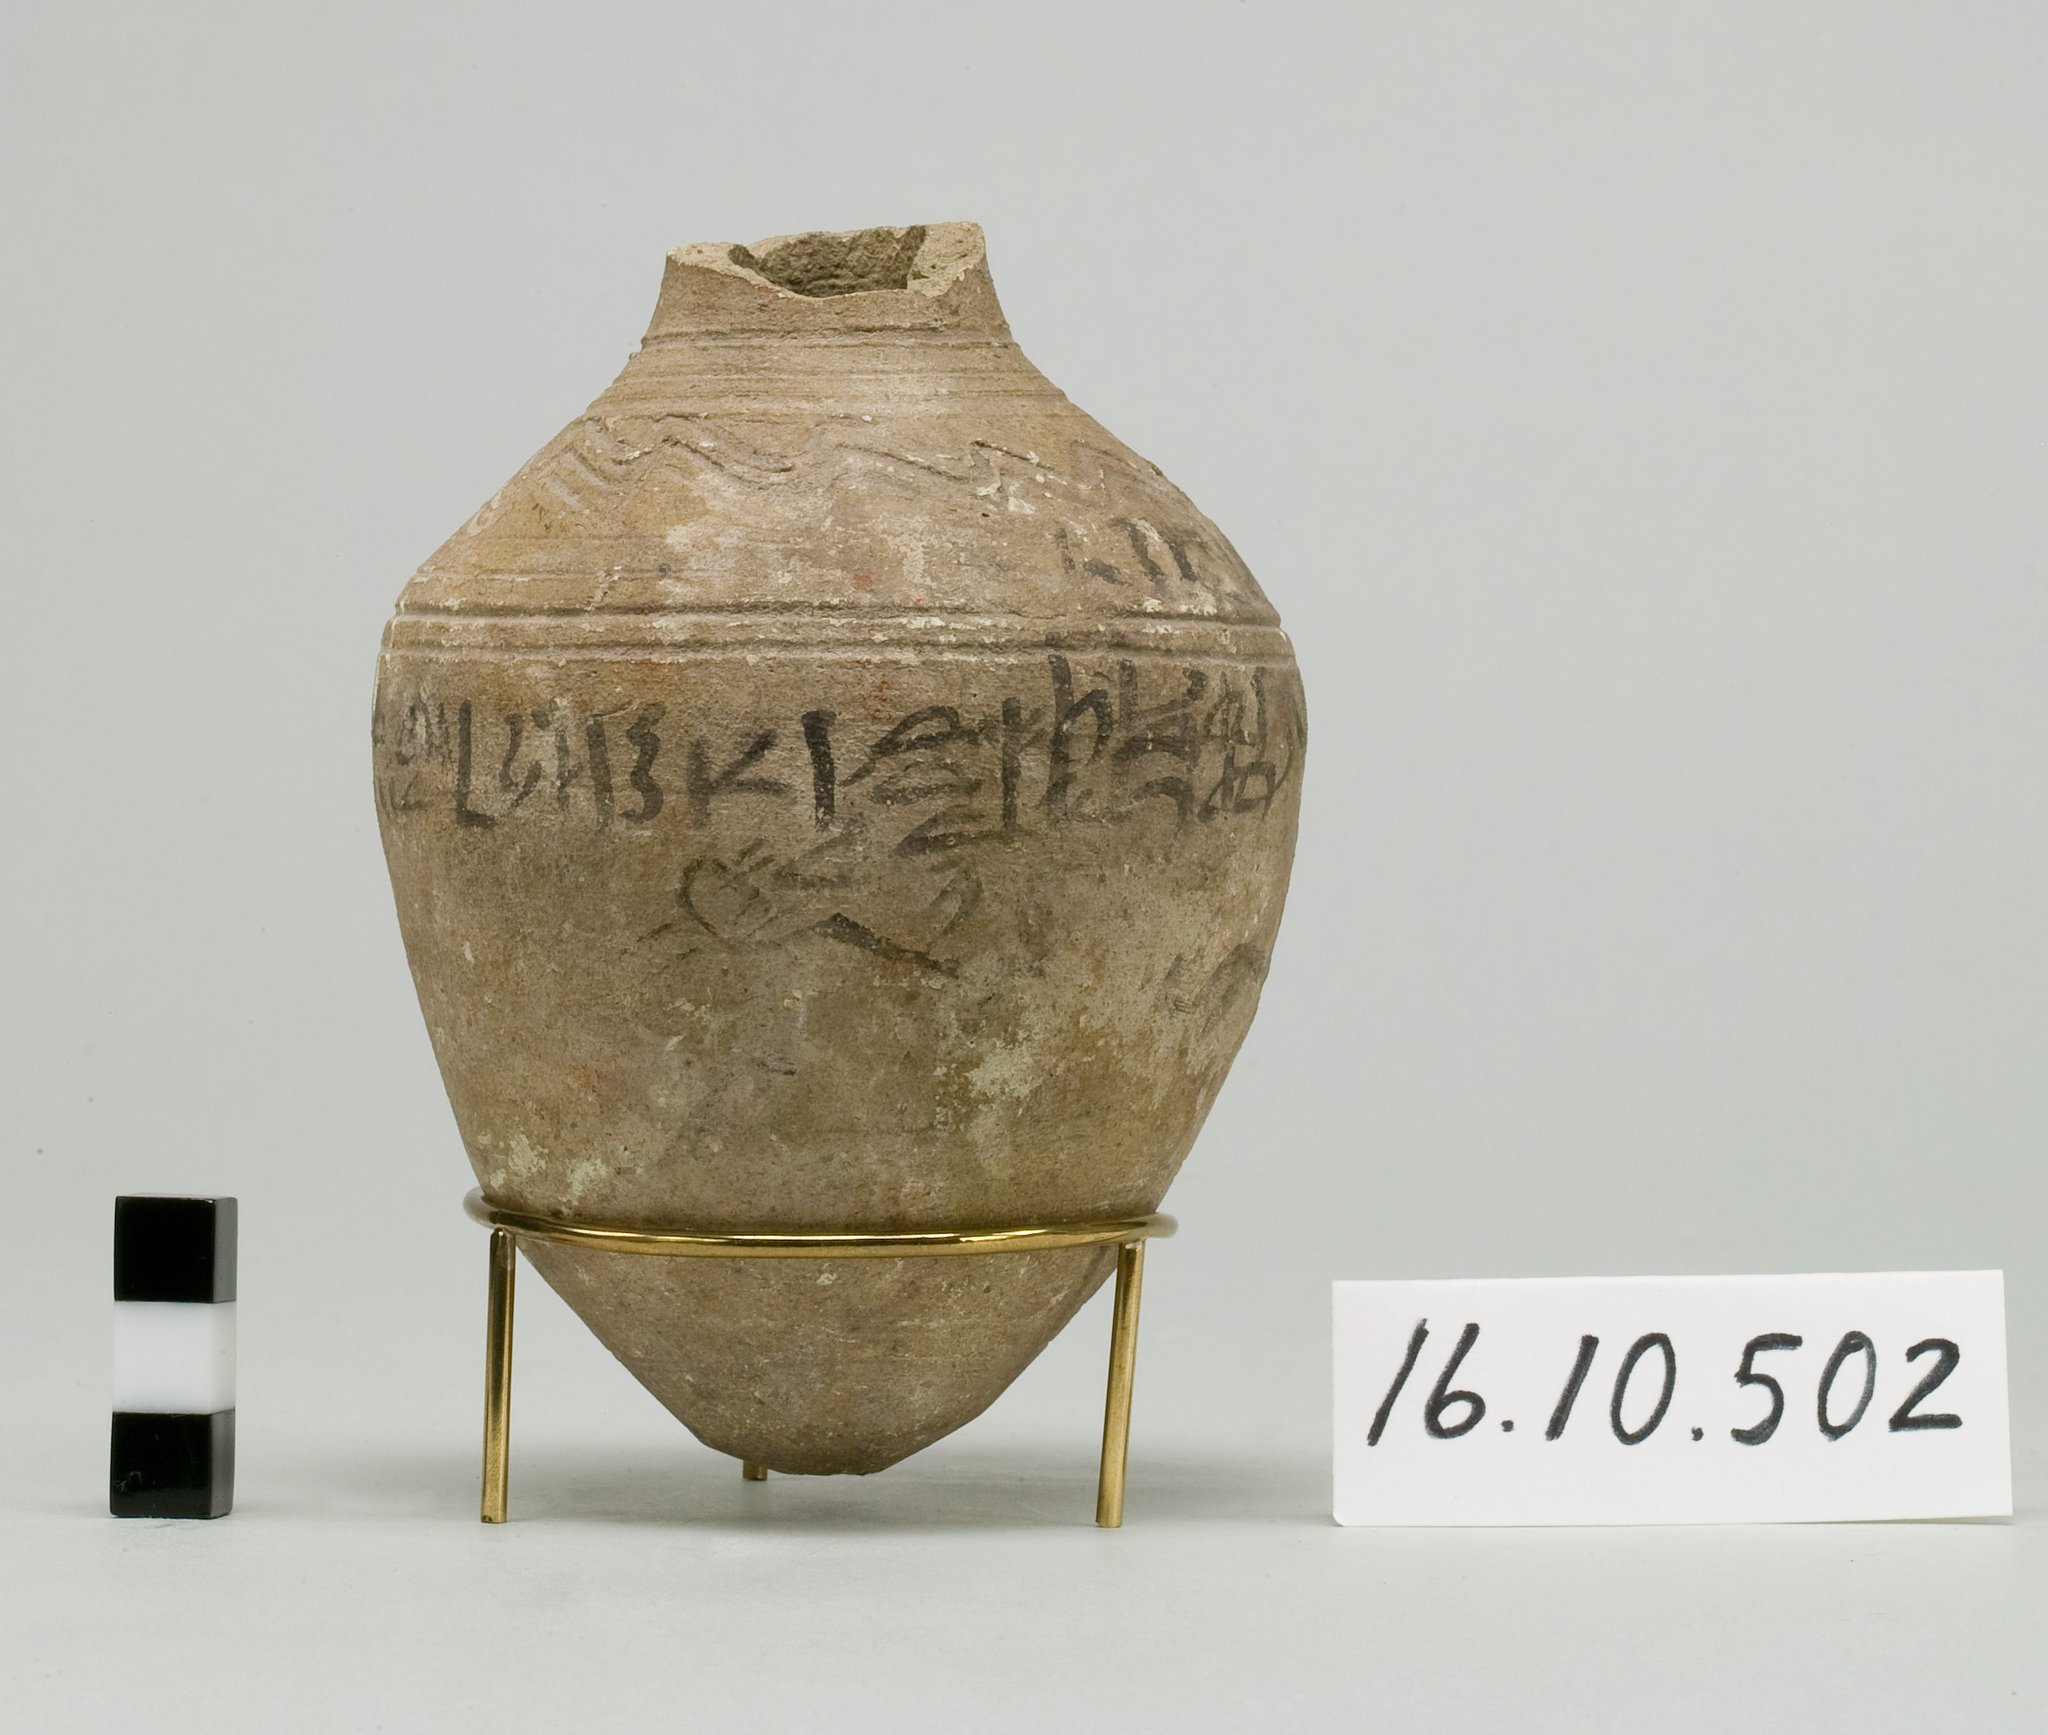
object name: jar, buff ware, inscribed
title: Jar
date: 1550-1458 BCE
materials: paint, pottery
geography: egypt